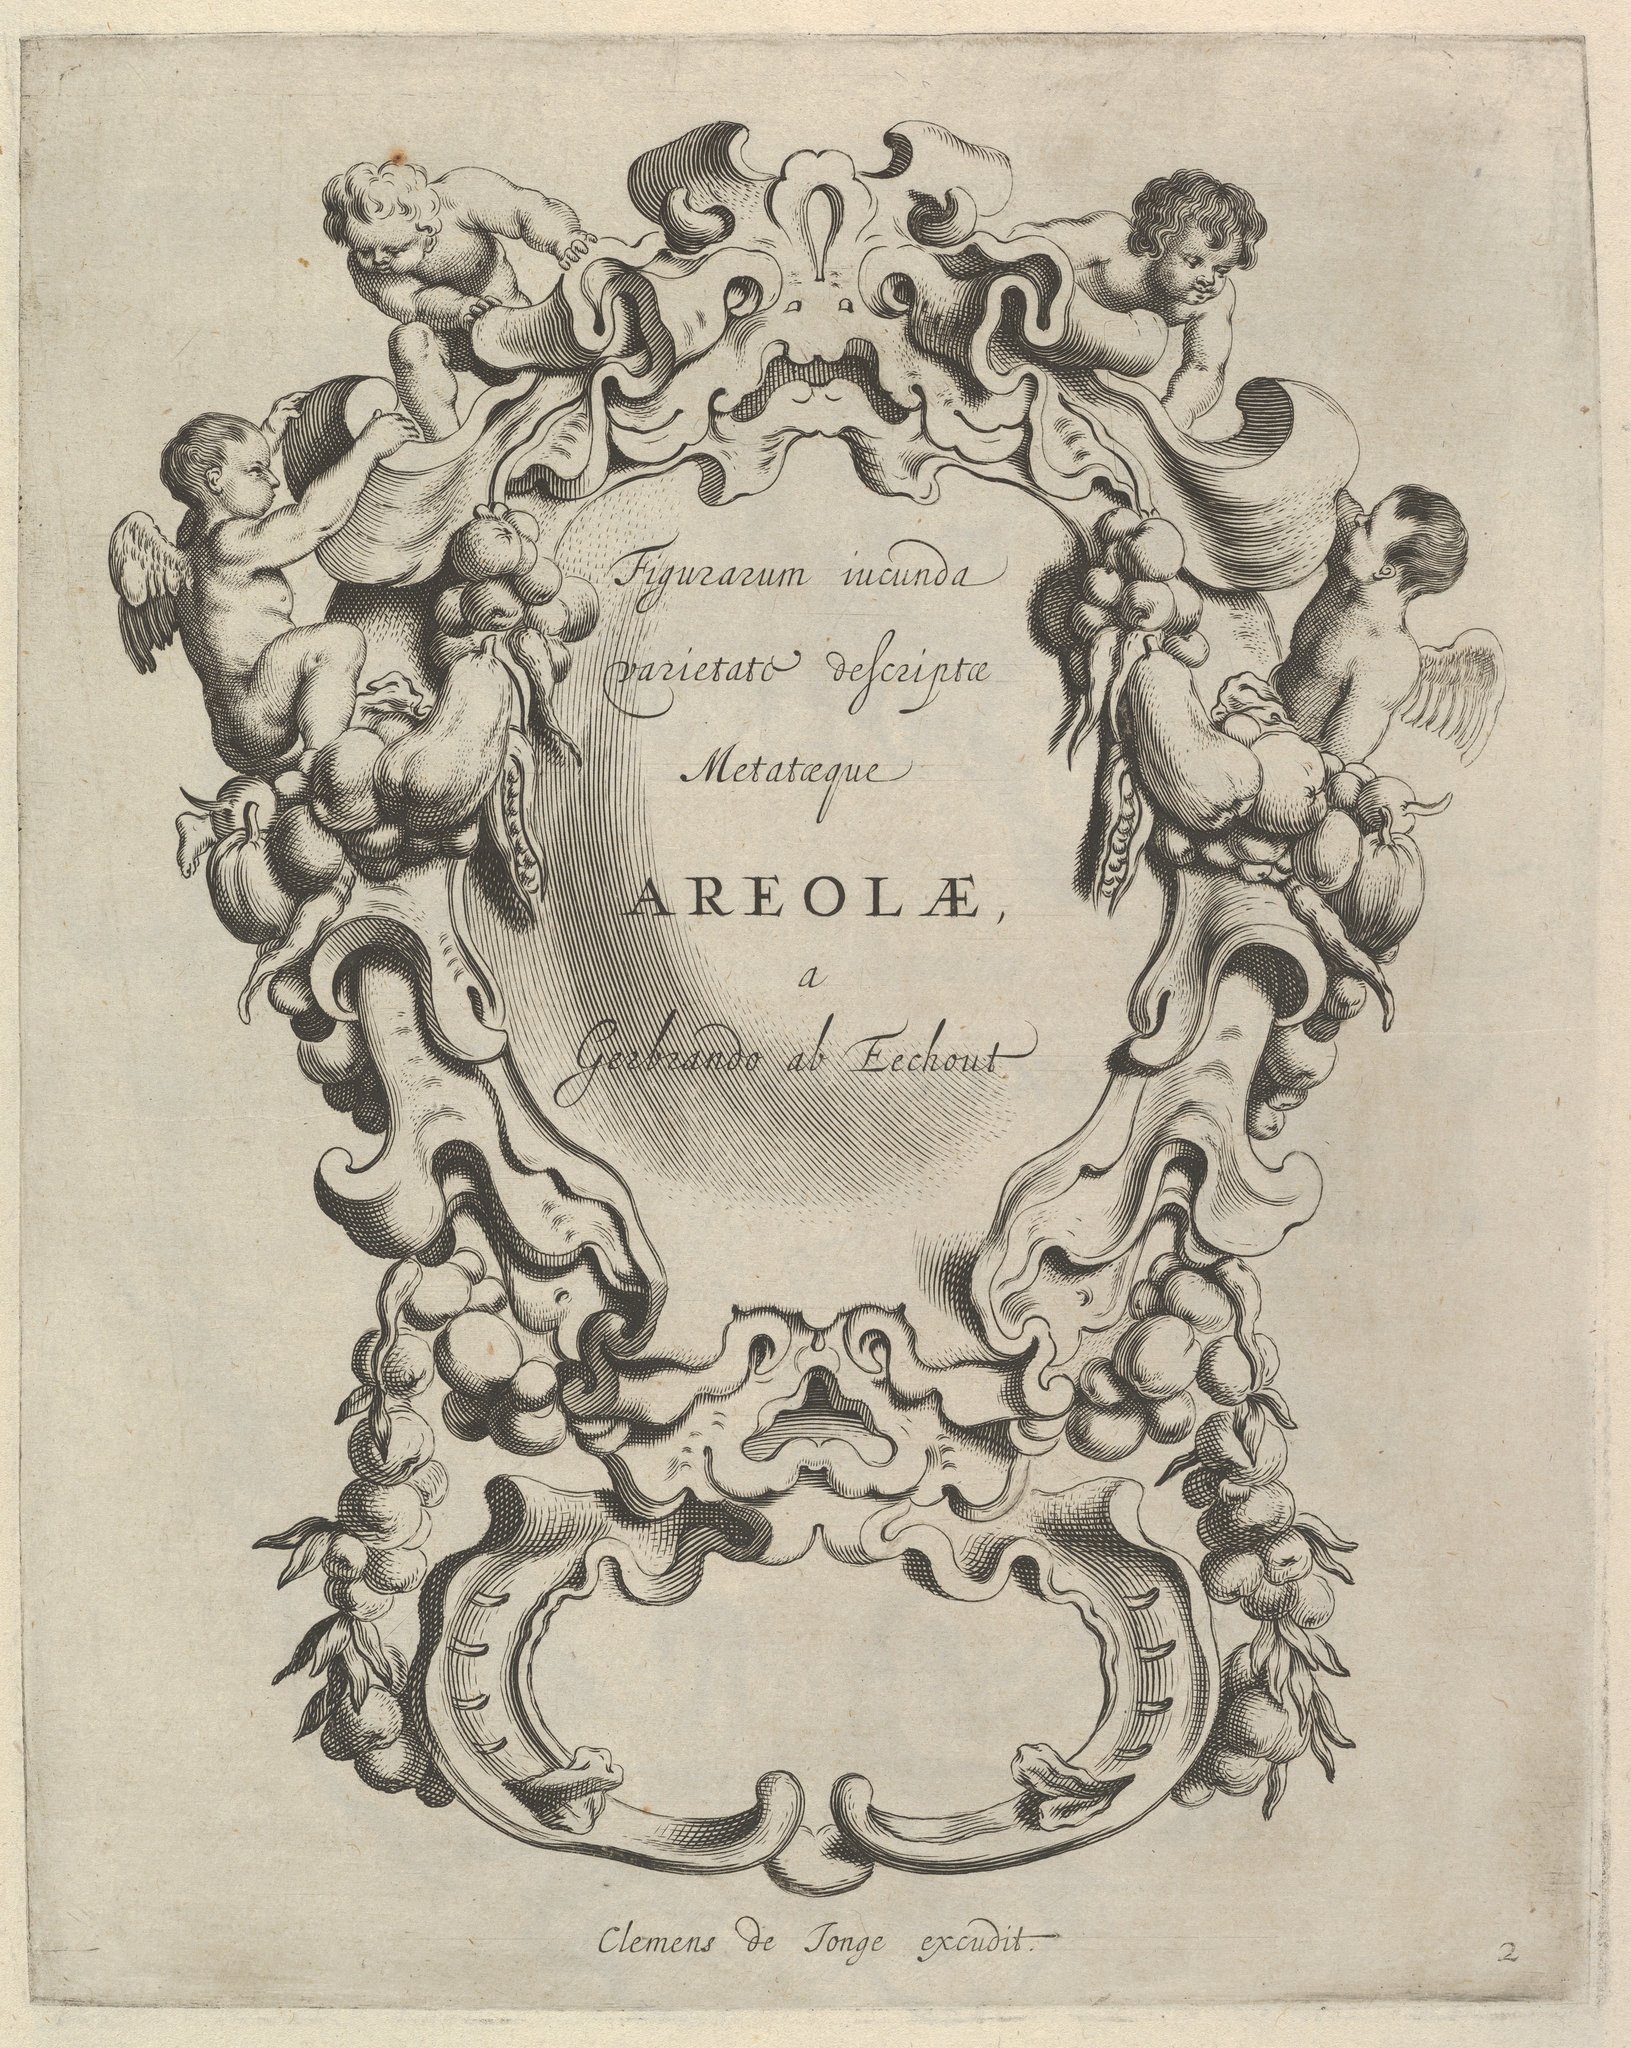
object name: album print ornament architecture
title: Veelderhande Niewe Compartimente (Titlepage in Latin)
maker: michiel mosyn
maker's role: engraver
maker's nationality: dutch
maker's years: 1630-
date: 1650-1674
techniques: engraving, etching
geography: netherlands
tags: cartouches